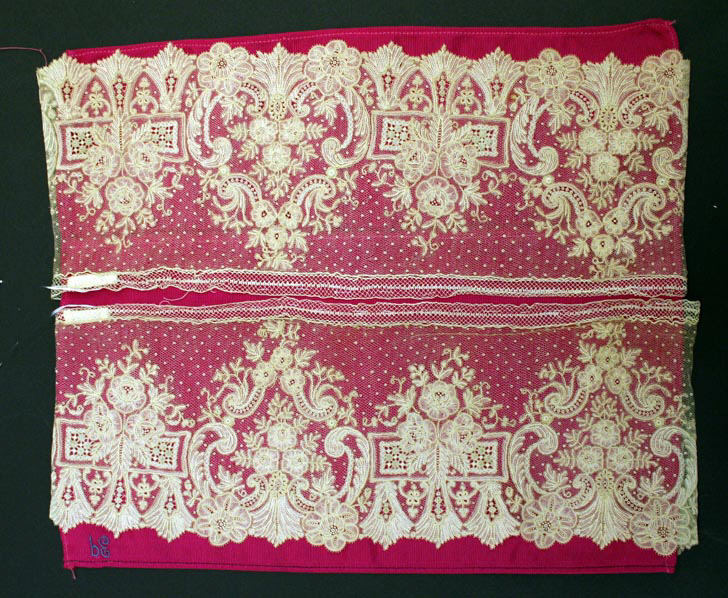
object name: cuff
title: Cuffs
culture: belgian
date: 1834-1866